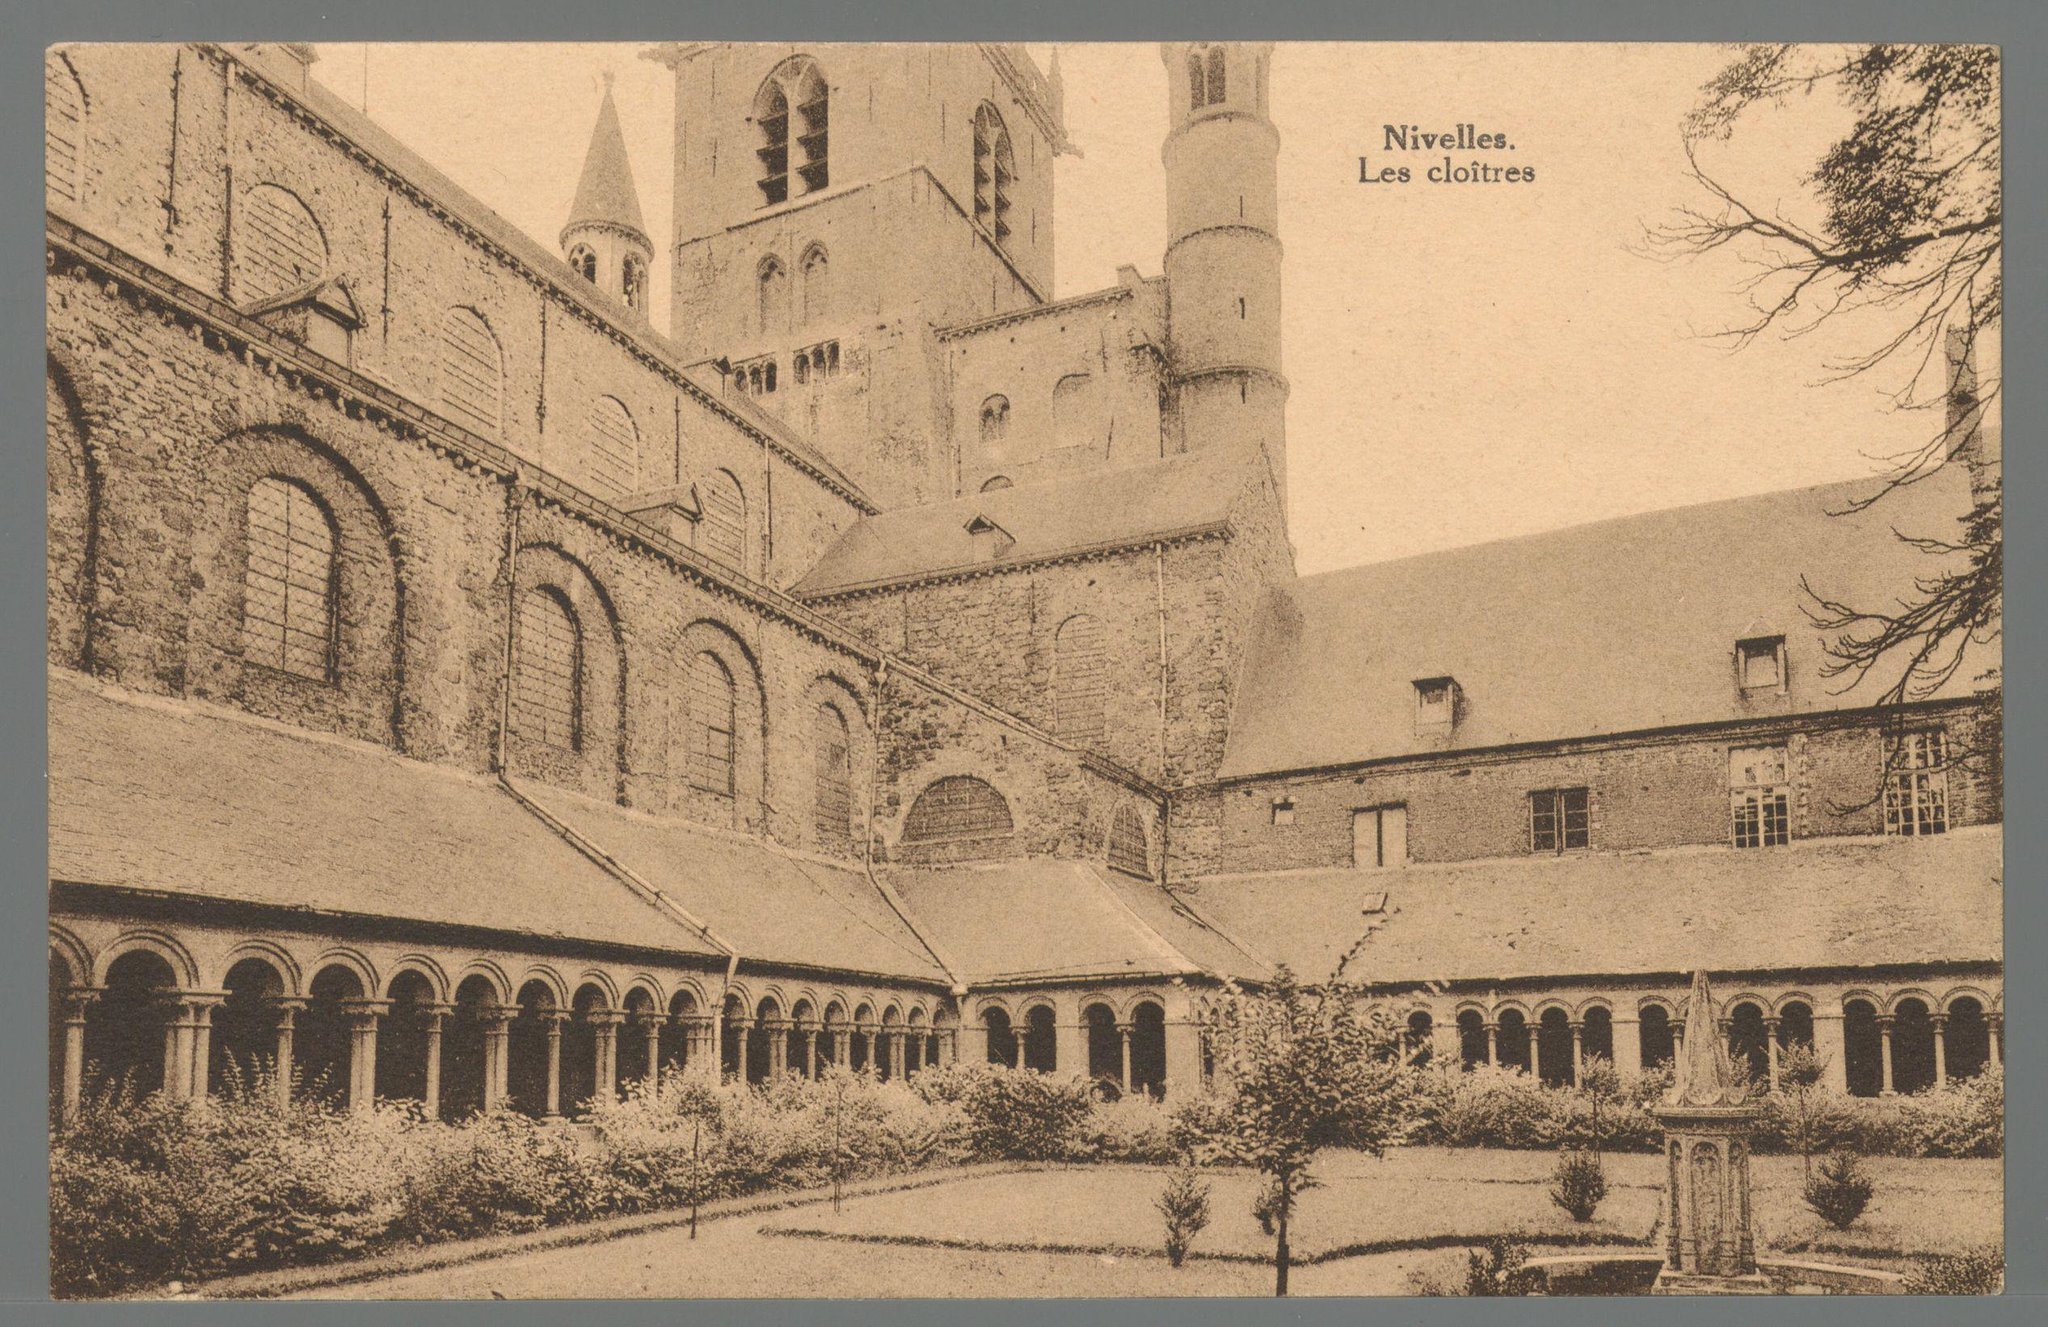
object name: ansichtkaart, prentbriefkaart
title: Nivelles. Les cloîtres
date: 1906-1930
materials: cardboard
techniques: photograph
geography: nivelles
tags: abbey, monastery, convent ~ roman catholic church, church (exterior)